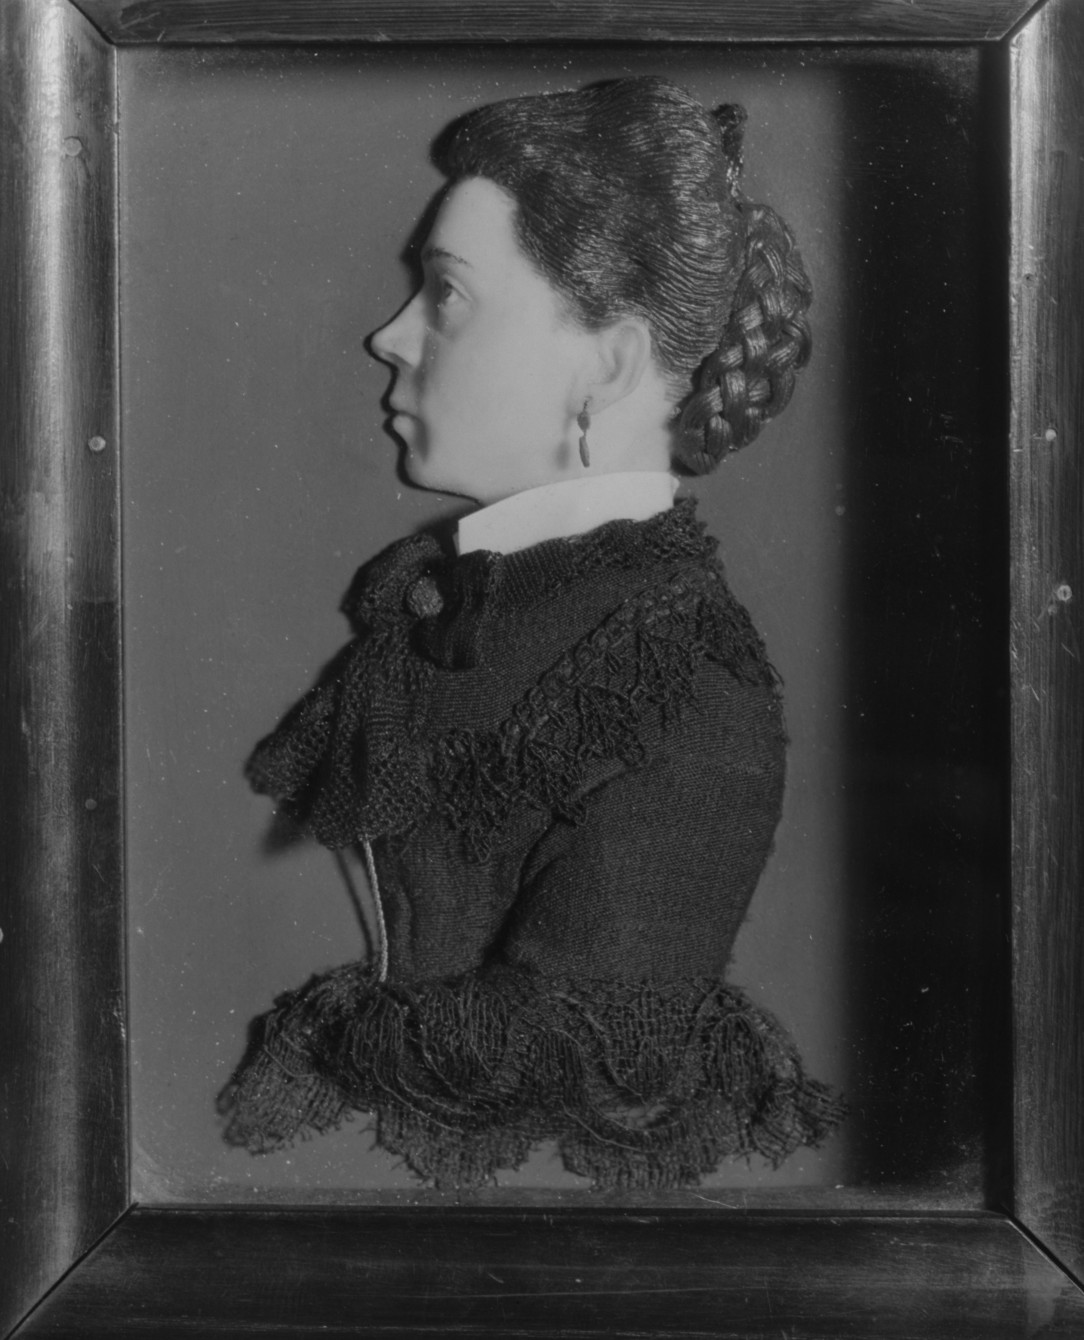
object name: relief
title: Portrait of a woman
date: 1867-1900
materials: textile, lace, wax, wood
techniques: painting, relief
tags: profiles,women